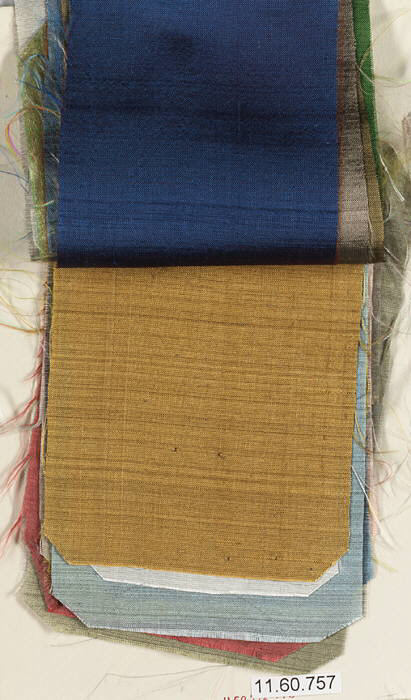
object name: sample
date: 1801-1833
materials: silk